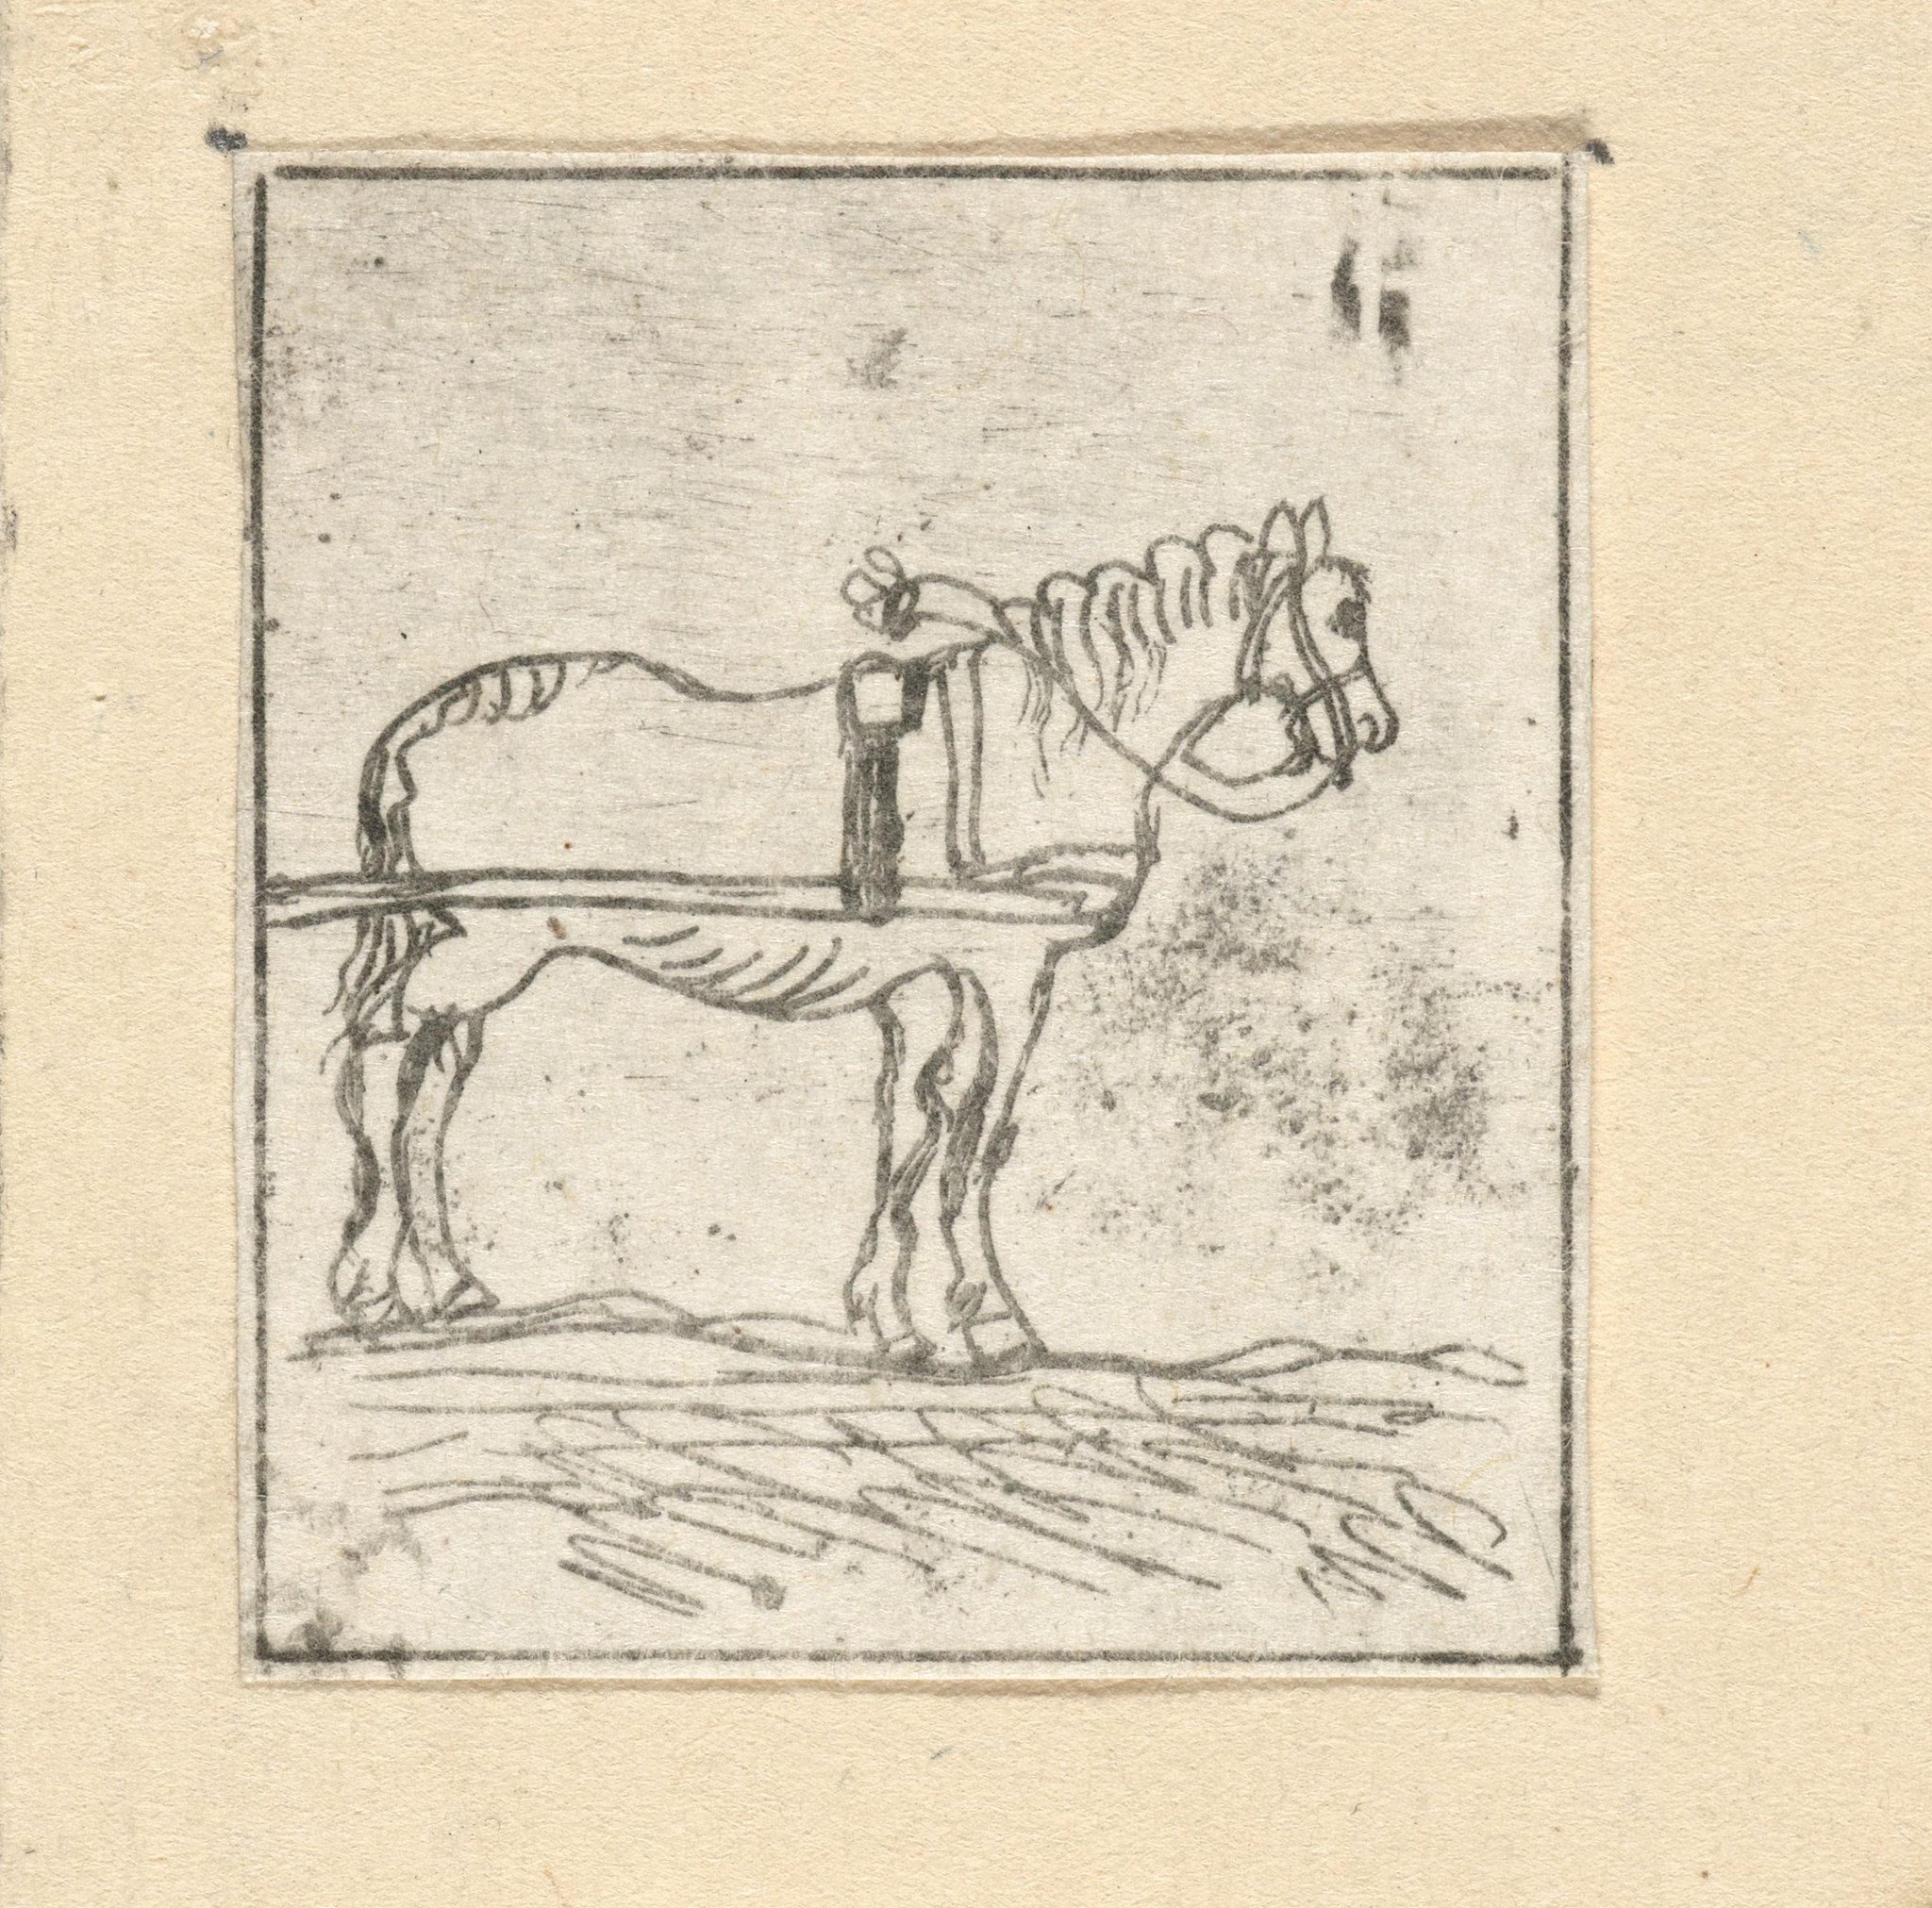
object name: print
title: Paard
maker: jacob hoolaart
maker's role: print maker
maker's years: 1713-1789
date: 1728-1789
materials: paper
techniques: etching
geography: dordrecht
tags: horses and kindred animals